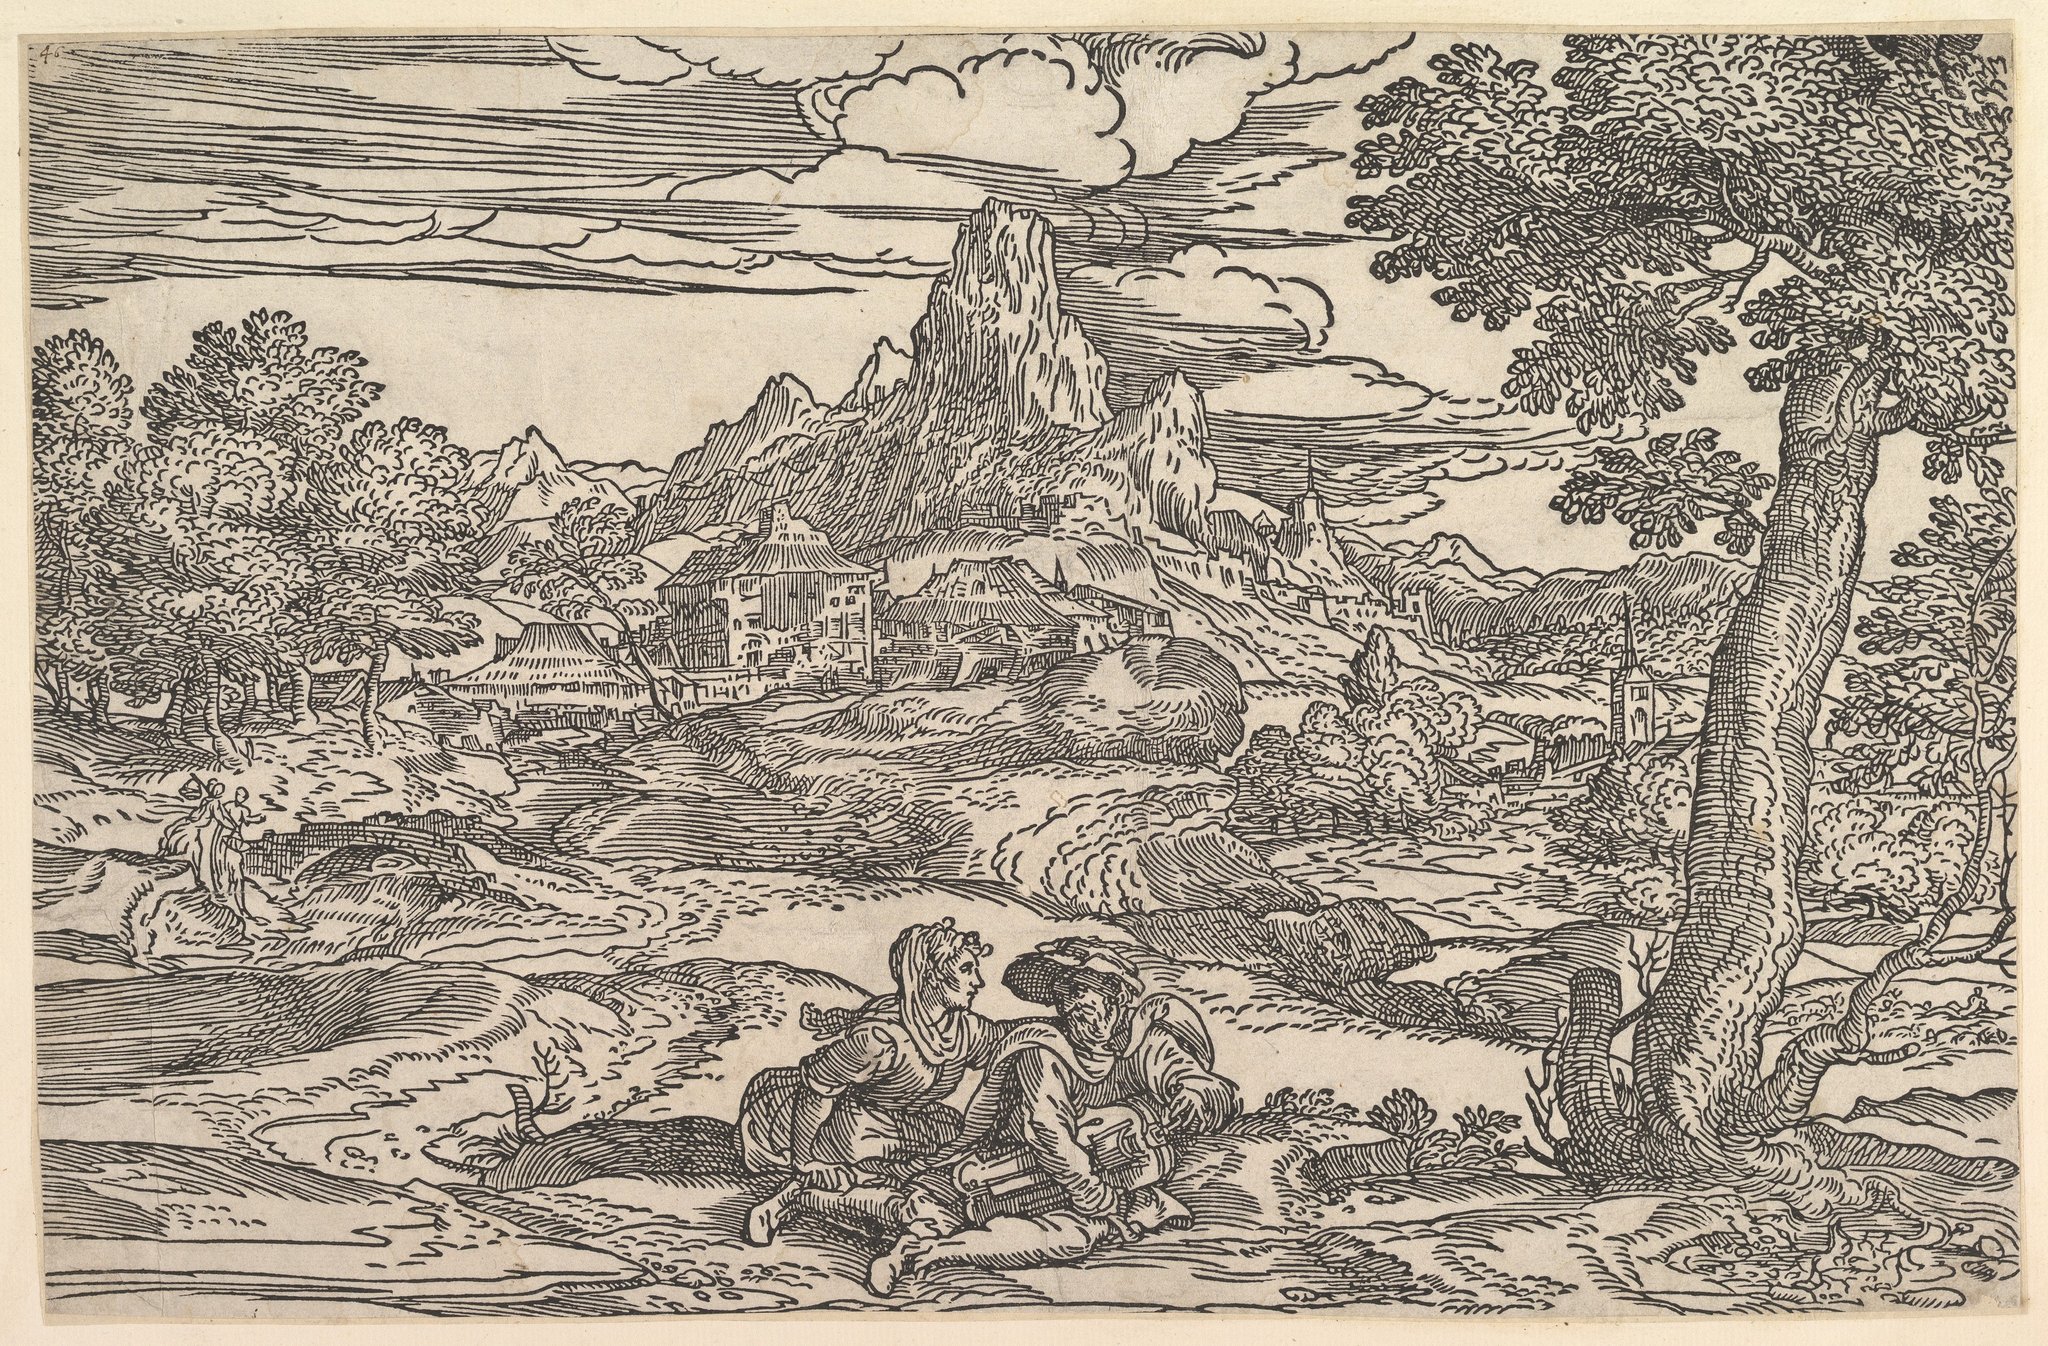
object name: print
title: Landscape with a woman seated next to a man playing a hurdy-gurdy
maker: domenico campagnola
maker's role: artist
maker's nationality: italian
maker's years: 1500-1564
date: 1540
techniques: woodcut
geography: venice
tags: musical instruments,men,women,landscapes,trees